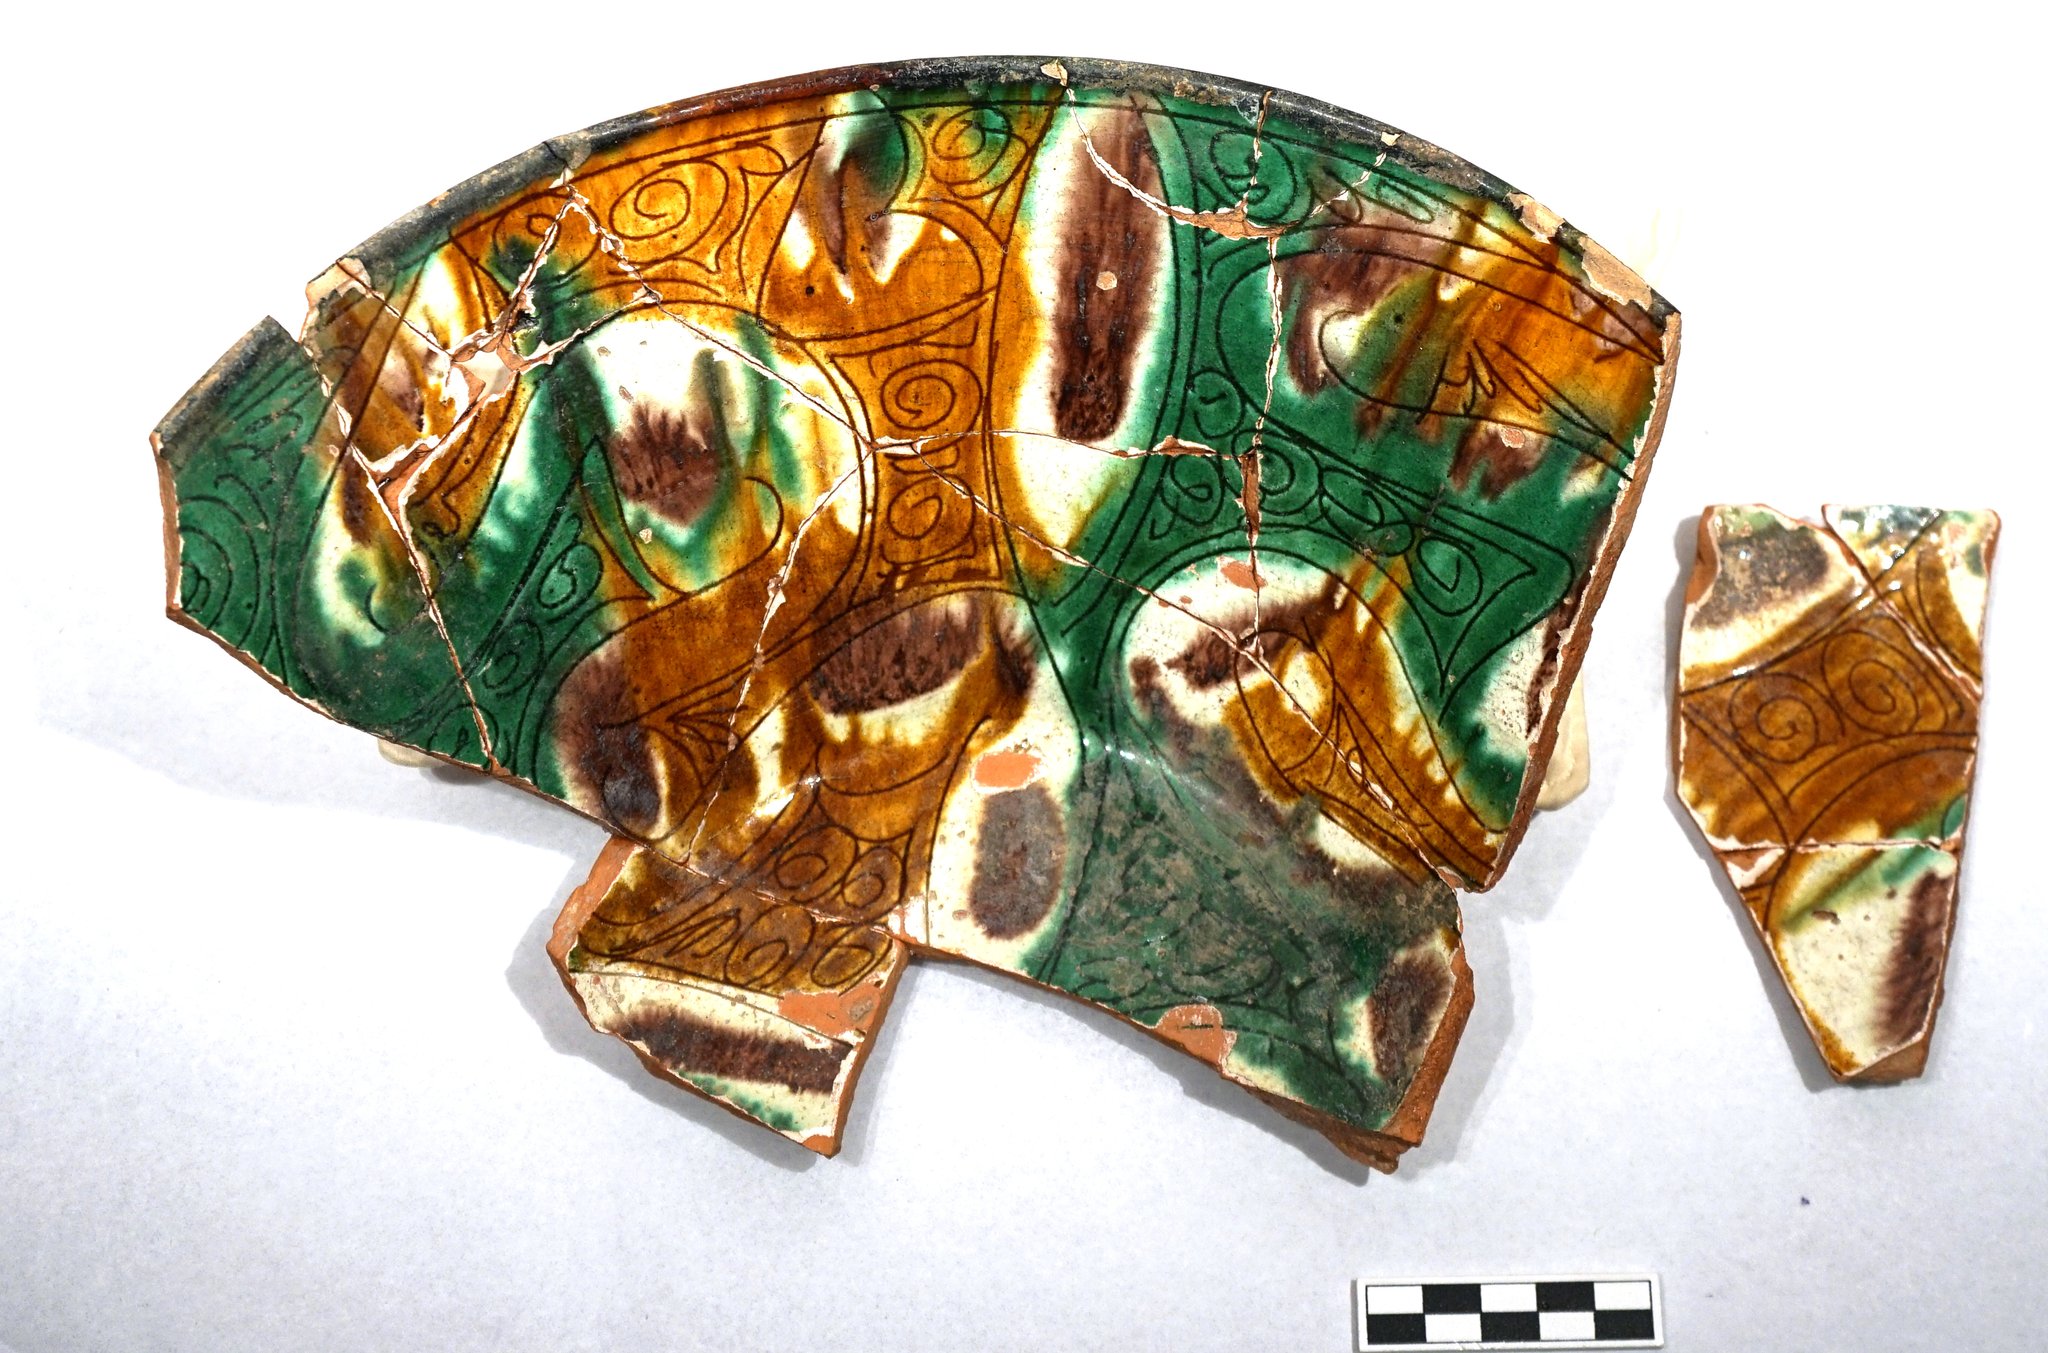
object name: fragment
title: Fragment of a Bowl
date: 901-1000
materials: earthenware, glaze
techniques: polychrome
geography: iran